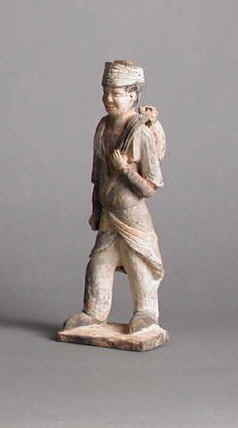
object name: figure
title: Man carrying a bag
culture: chinese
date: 601-700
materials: earthenware, pigment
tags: men